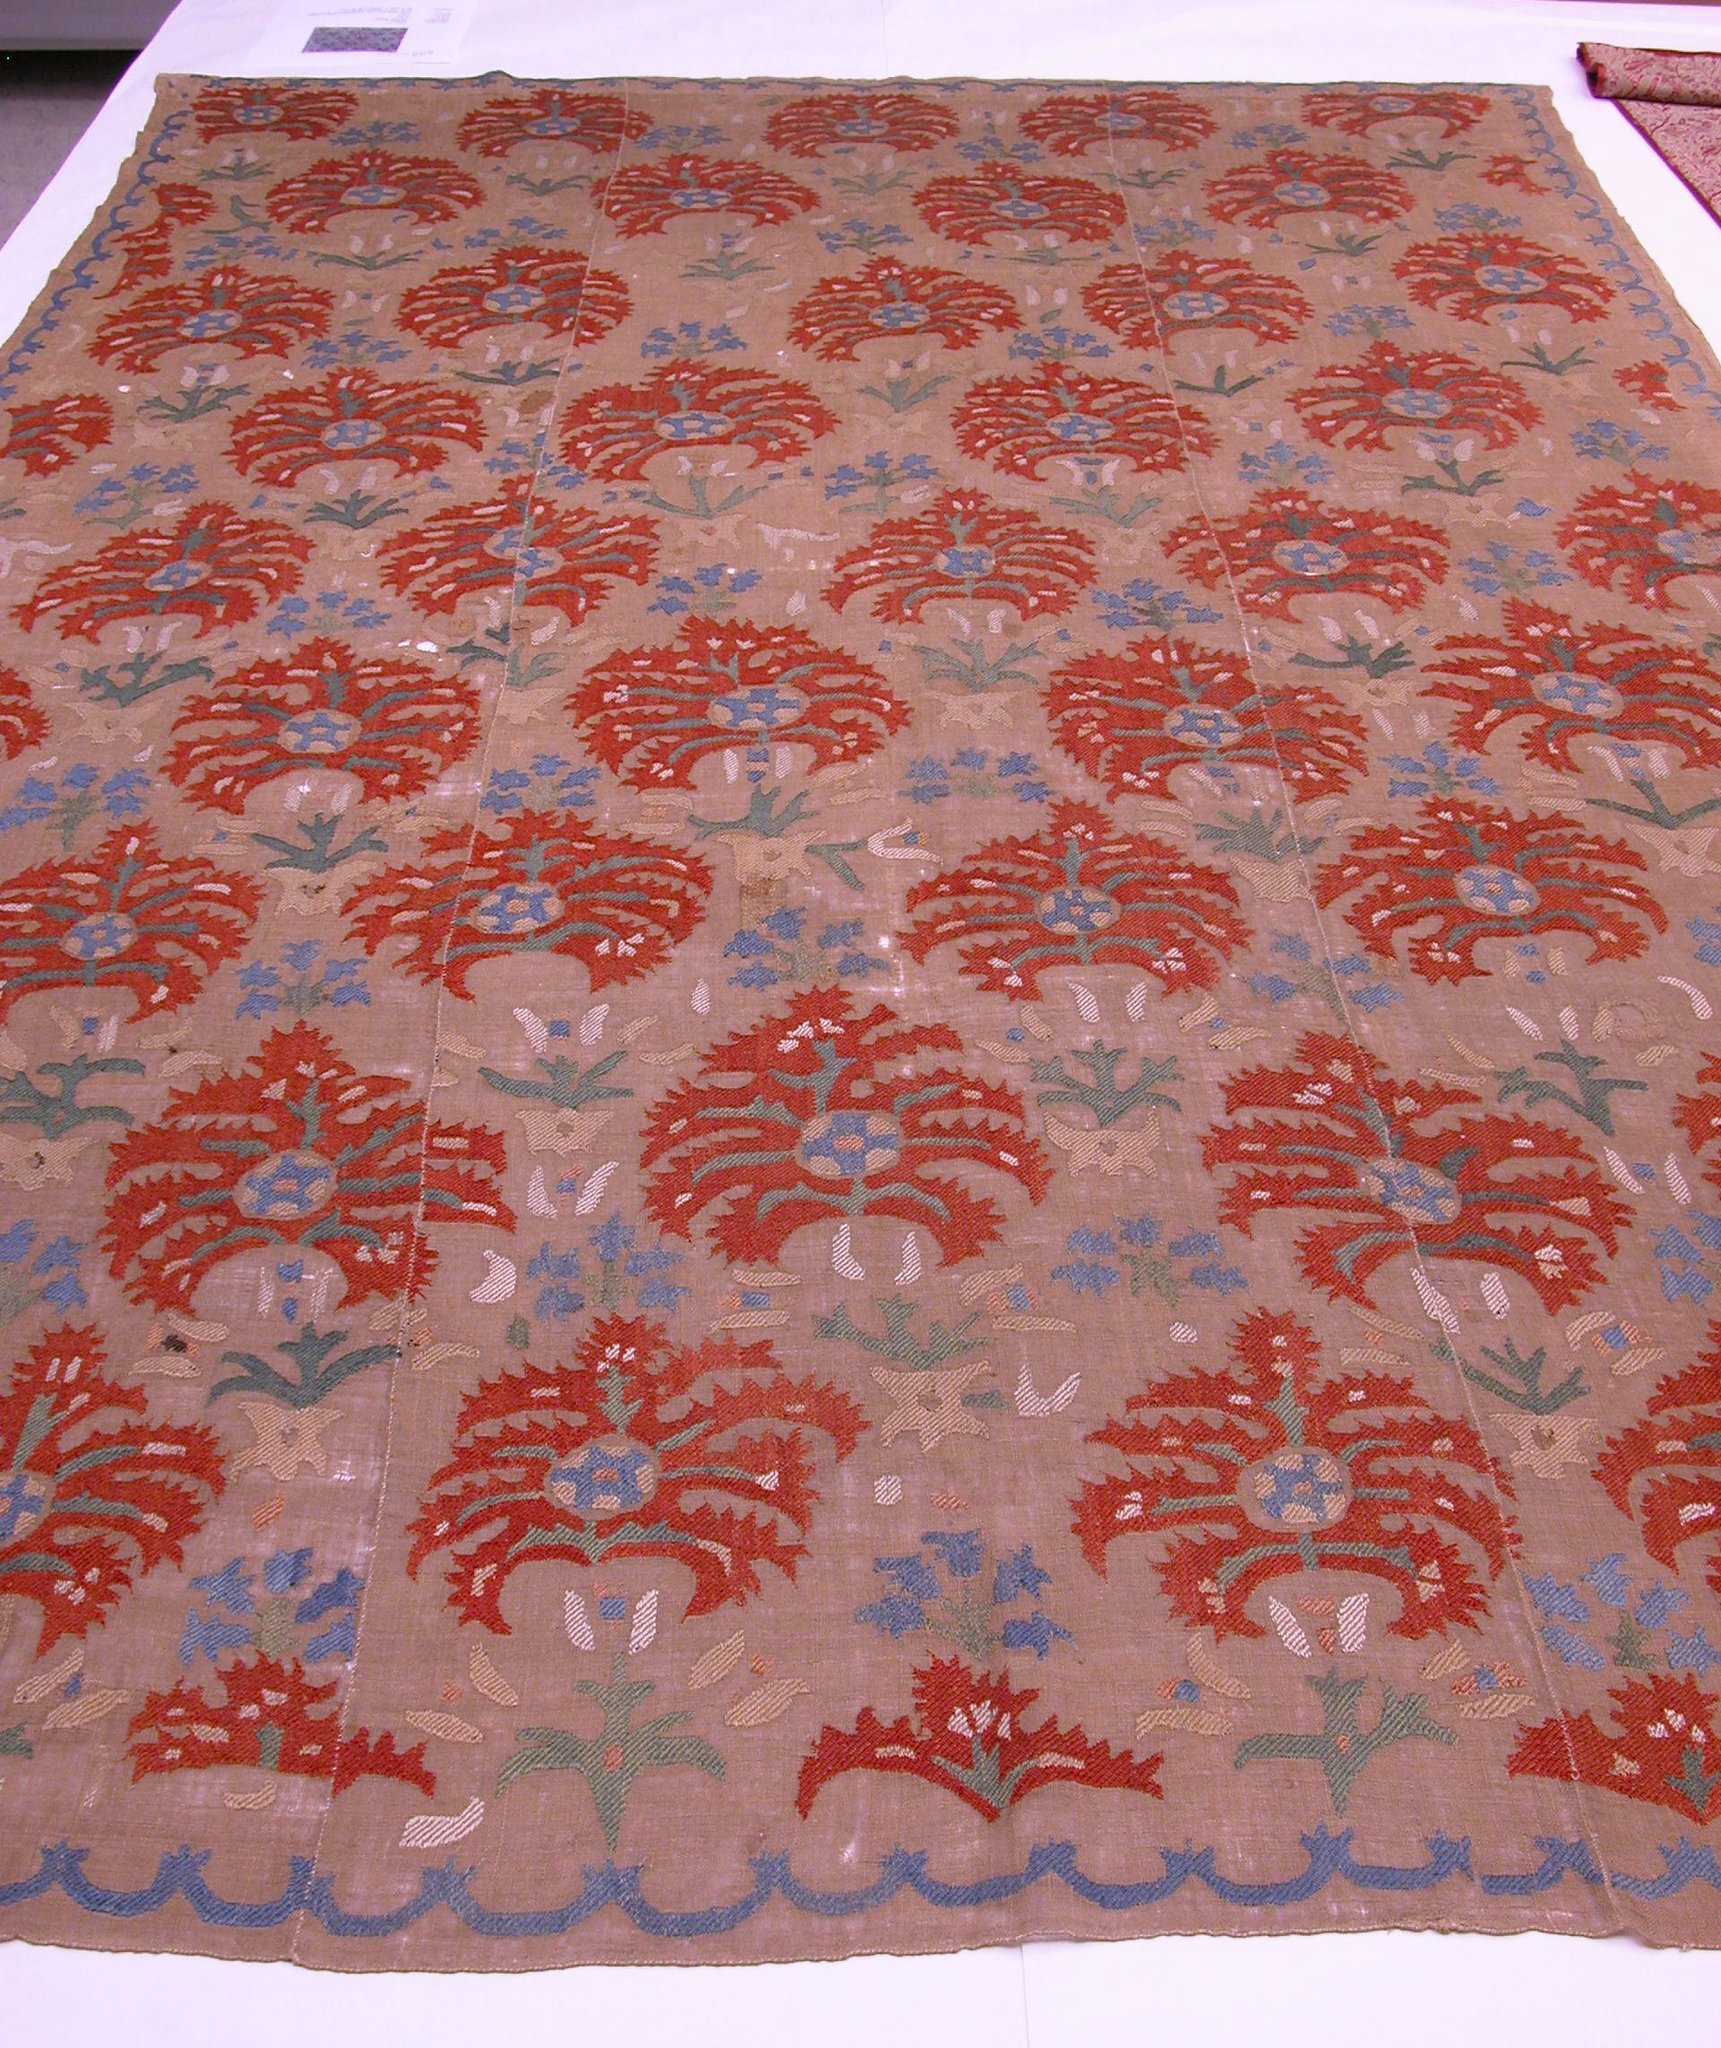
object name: hanging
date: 1601-1800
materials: linen, silk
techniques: embroidery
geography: turkey